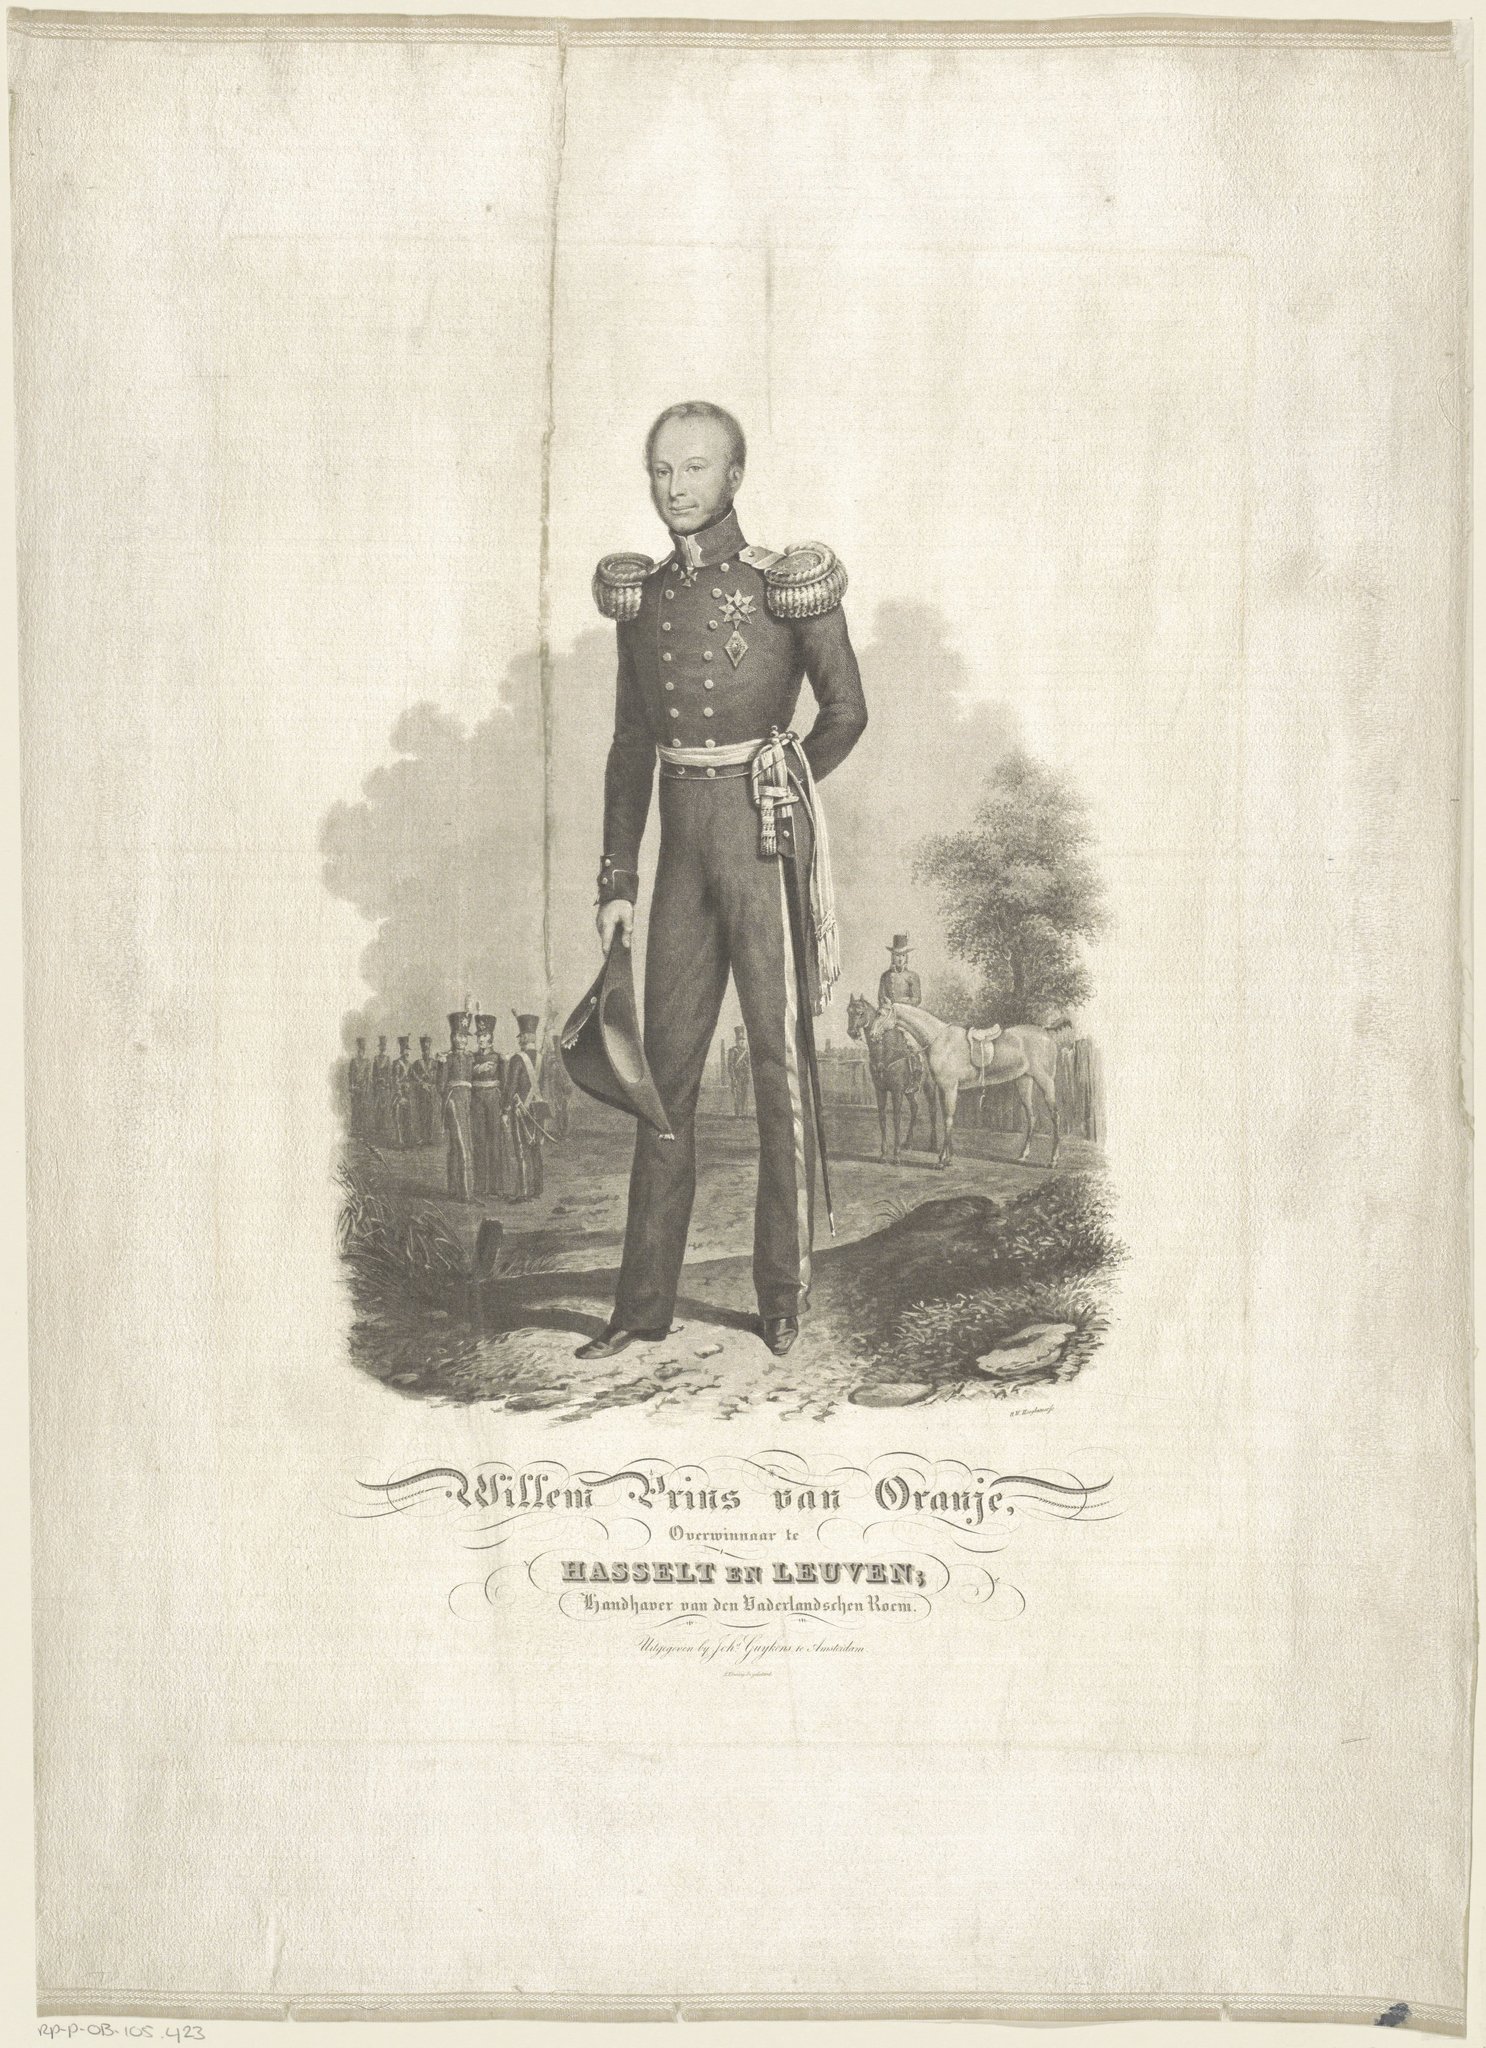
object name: print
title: Portret van Willem II, koning der Nederlanden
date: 1831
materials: silk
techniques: aquatint, etching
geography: amsterdam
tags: the hague, william ii of the netherlands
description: Portret van Willem II. In zijn rechterhand zijn hoed. Op de achtergrond soldaten. In de ondermarge vier regels Nederlandse tekst over de Slag bij Hasselt en de Slag bij Leuven, van 8 tot 12 augustus 1831.